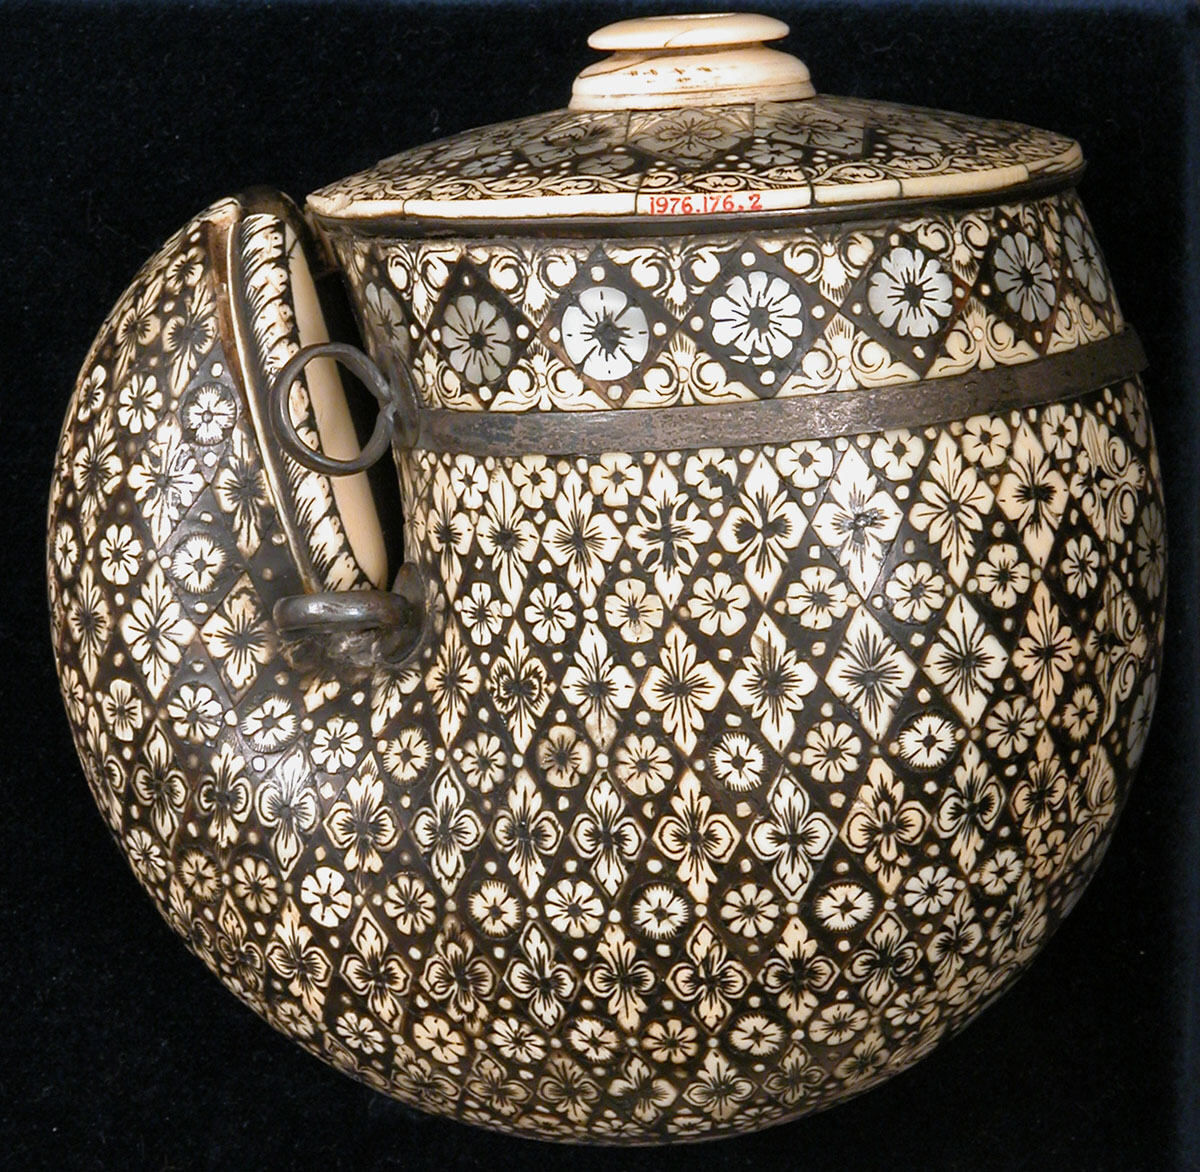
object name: powder horn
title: Inlaid Powder Horn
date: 1701-1800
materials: horn, ivory, mother of pearl, silver, wood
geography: india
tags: military equipment,flowers